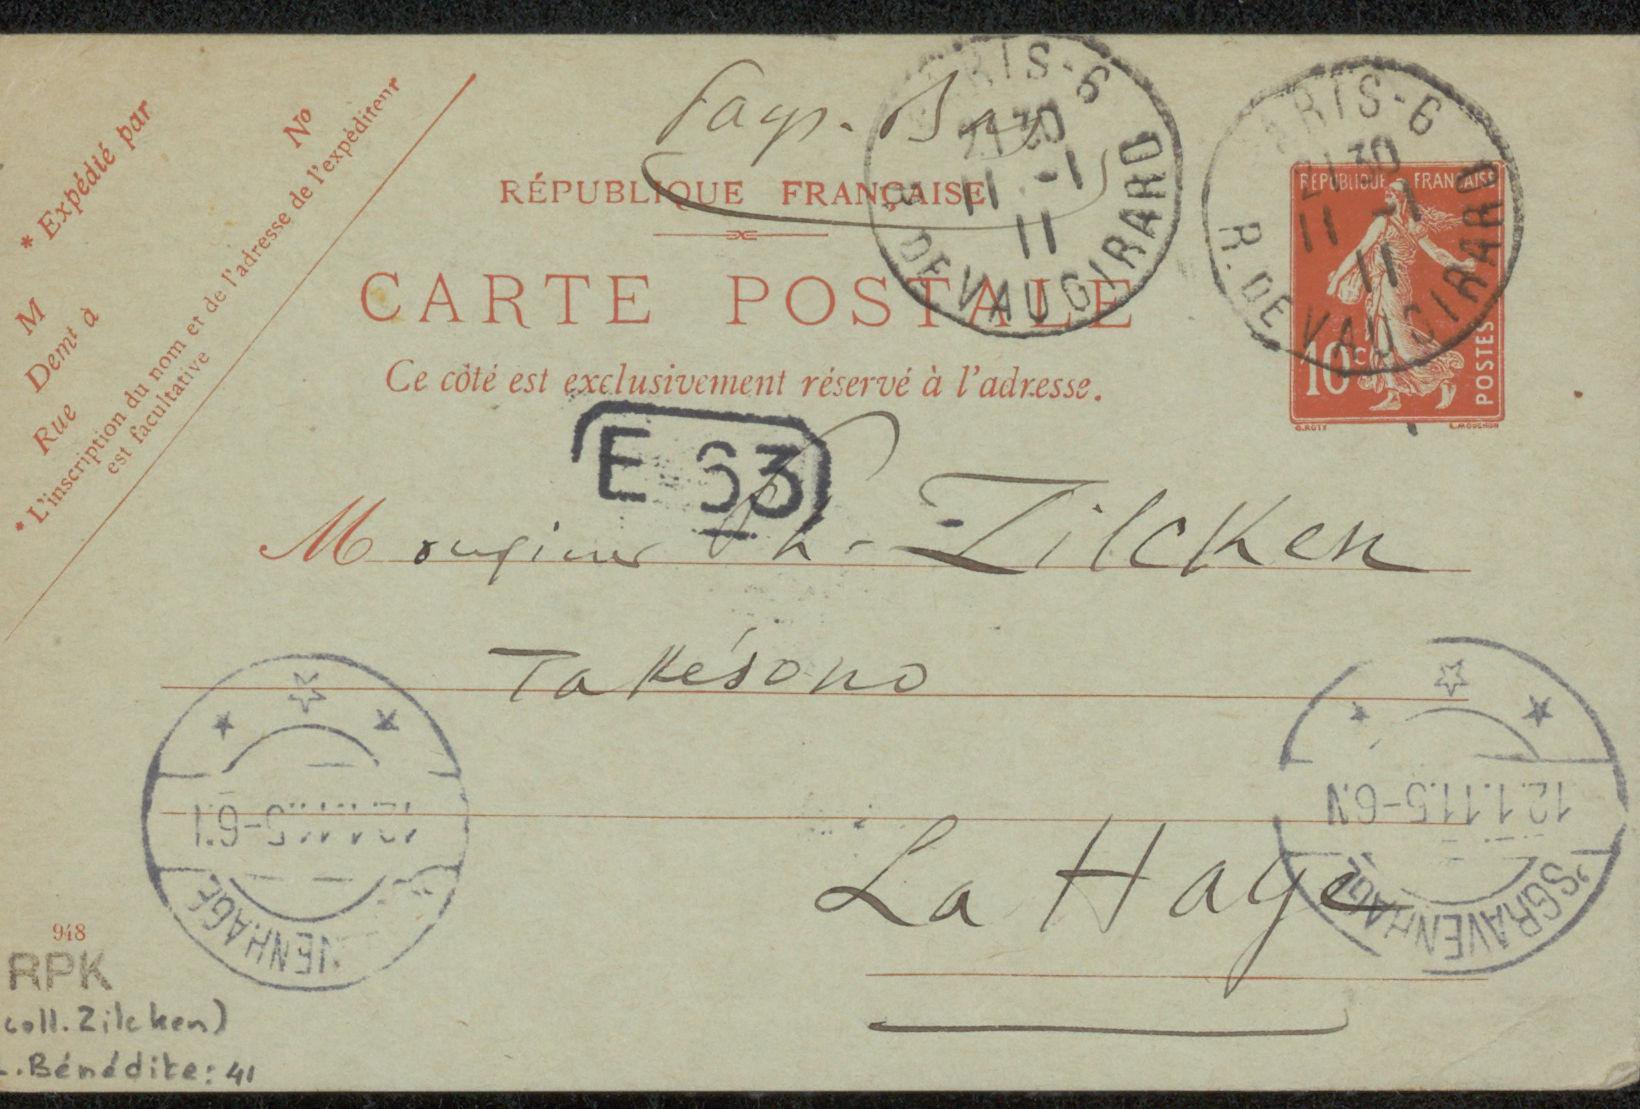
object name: postcard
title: Briefkaart aan Philip Zilcken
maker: léonce bénédite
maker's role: conservator, museumdirecteur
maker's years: 1856-1925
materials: cardboard, ink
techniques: pen, writing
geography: paris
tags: the hague, painter, draughtsman, philip zilcken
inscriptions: collector's mark: ‘RPK’